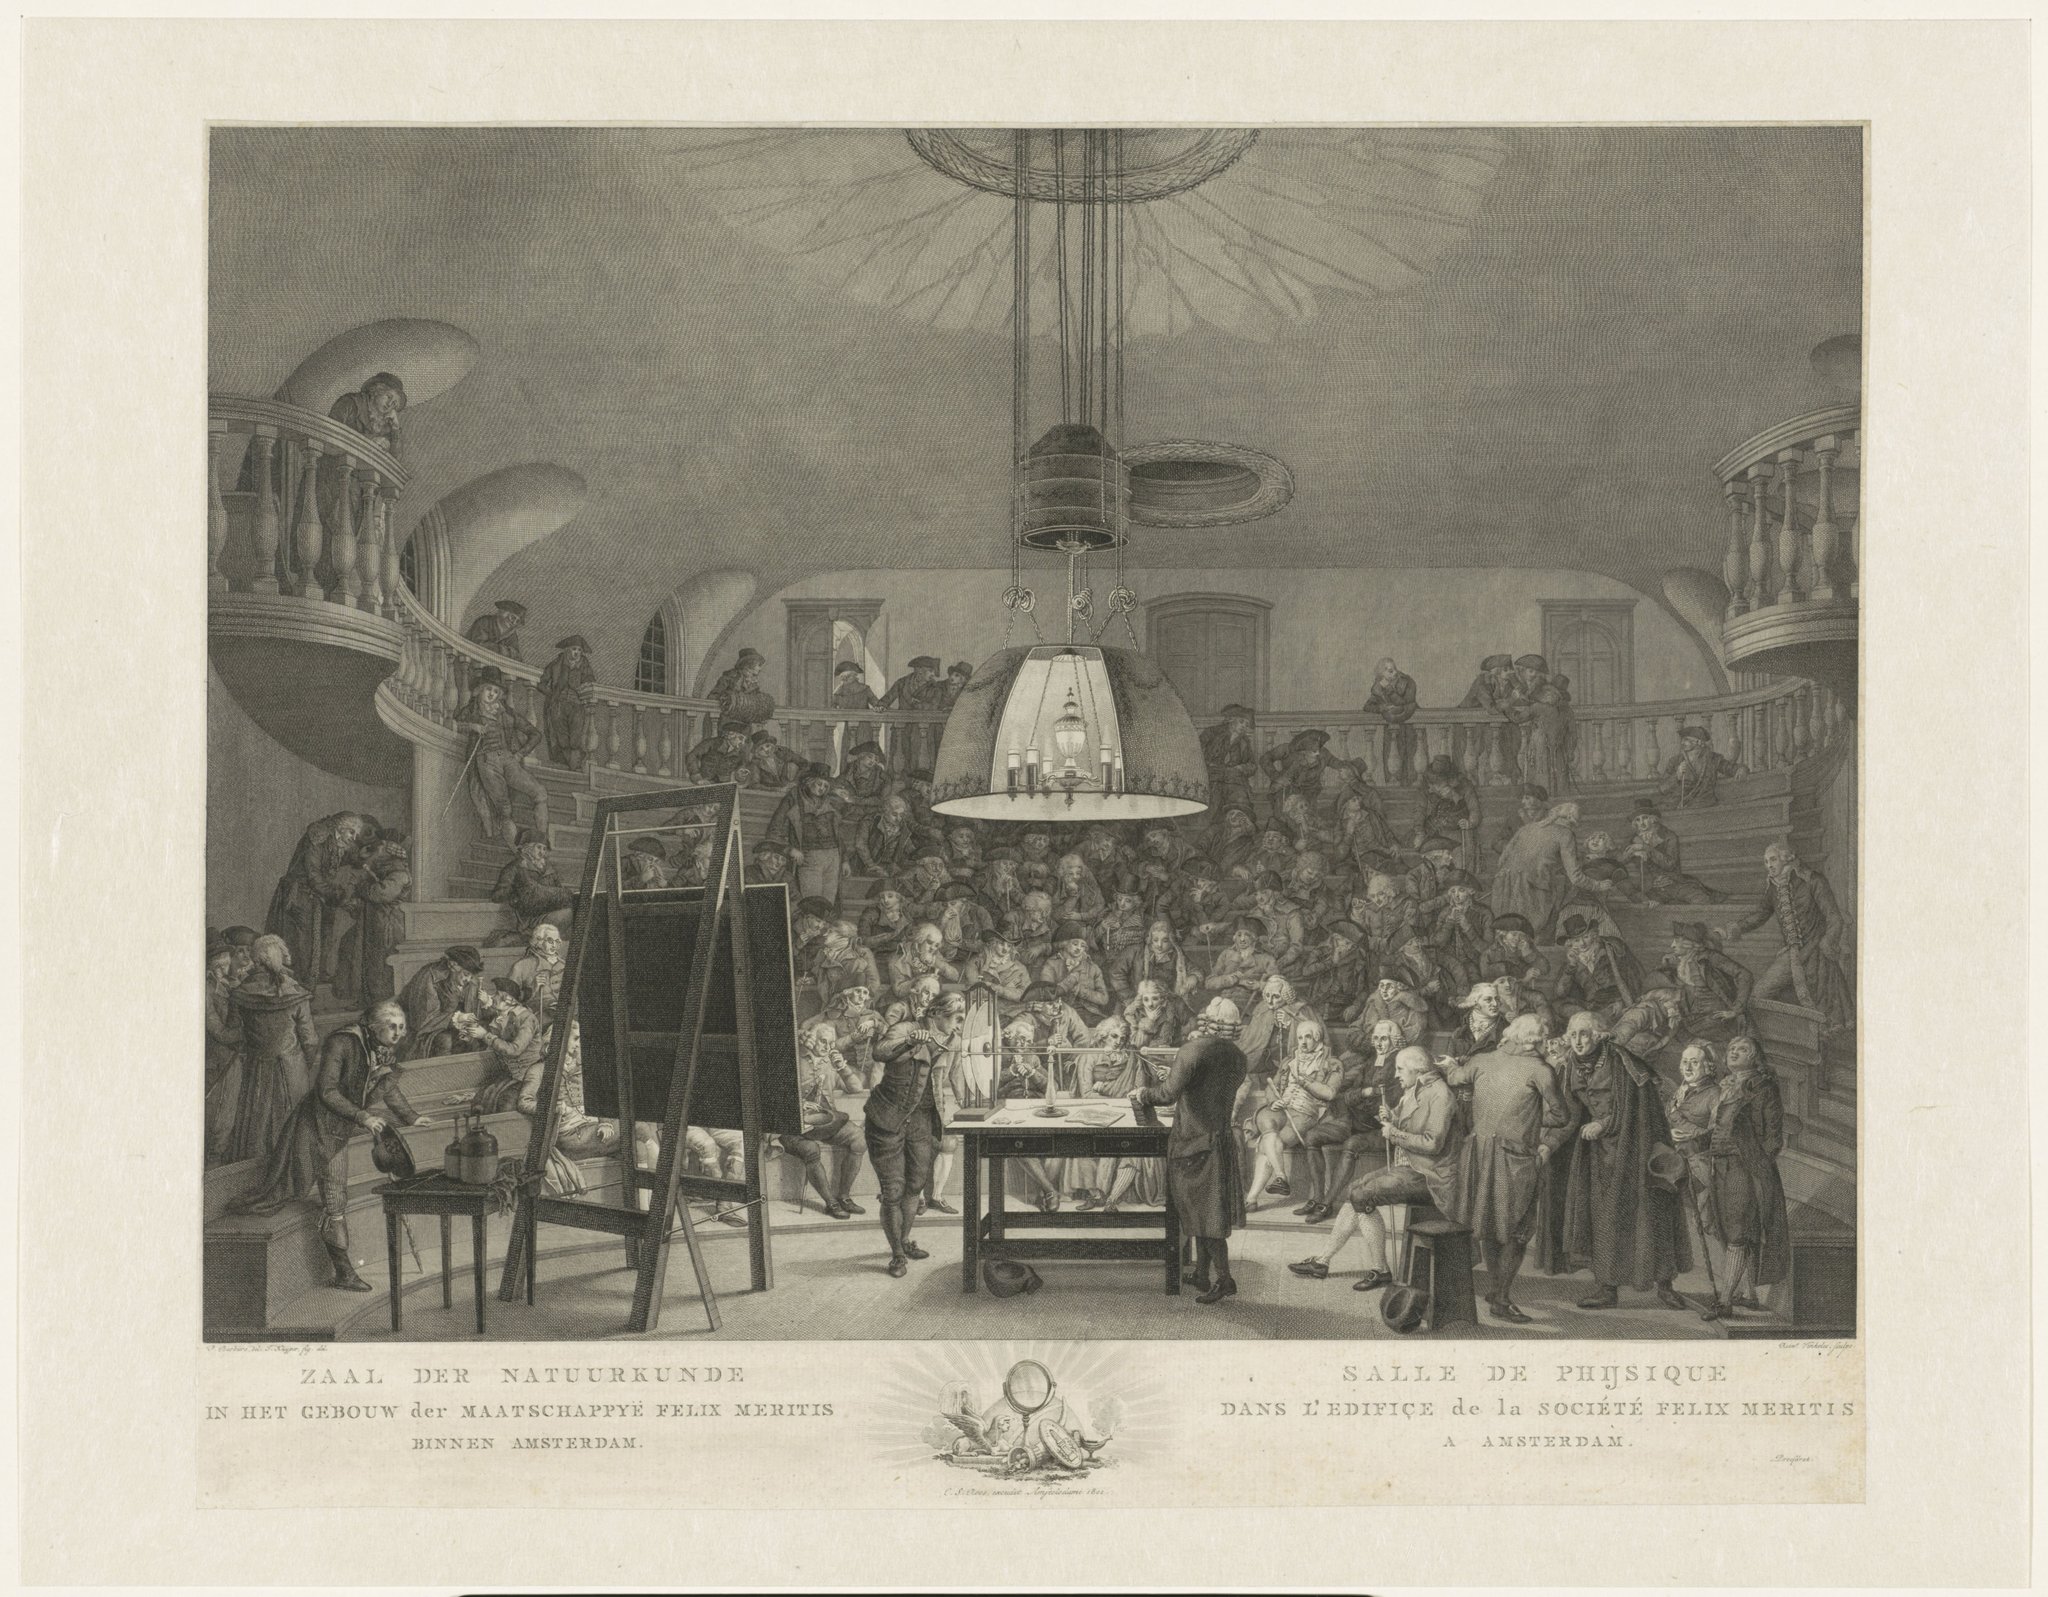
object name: print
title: Zaal der Natuurkunde in het Gebouw der Maatschappyë Felix Meritis binnen Amsterdam / Salle de Phijsique dans l'Edifiçe de la Société Felix Meritis a Amsterdam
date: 1801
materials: paper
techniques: engraving, etching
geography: amsterdam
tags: physics, learned society, academy of sciences, physics (+ tools, instruments; laboratory equipment ~ scientific research)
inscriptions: collector's mark: Lugt 2228, inscription: ‘... S. Roos’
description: Demonstratie van de elektriseermachine in de Zaal der Natuurkunde in het gebouw van de maatschappij Felix Meritis te Amsterdam, ingewijd in 1789.